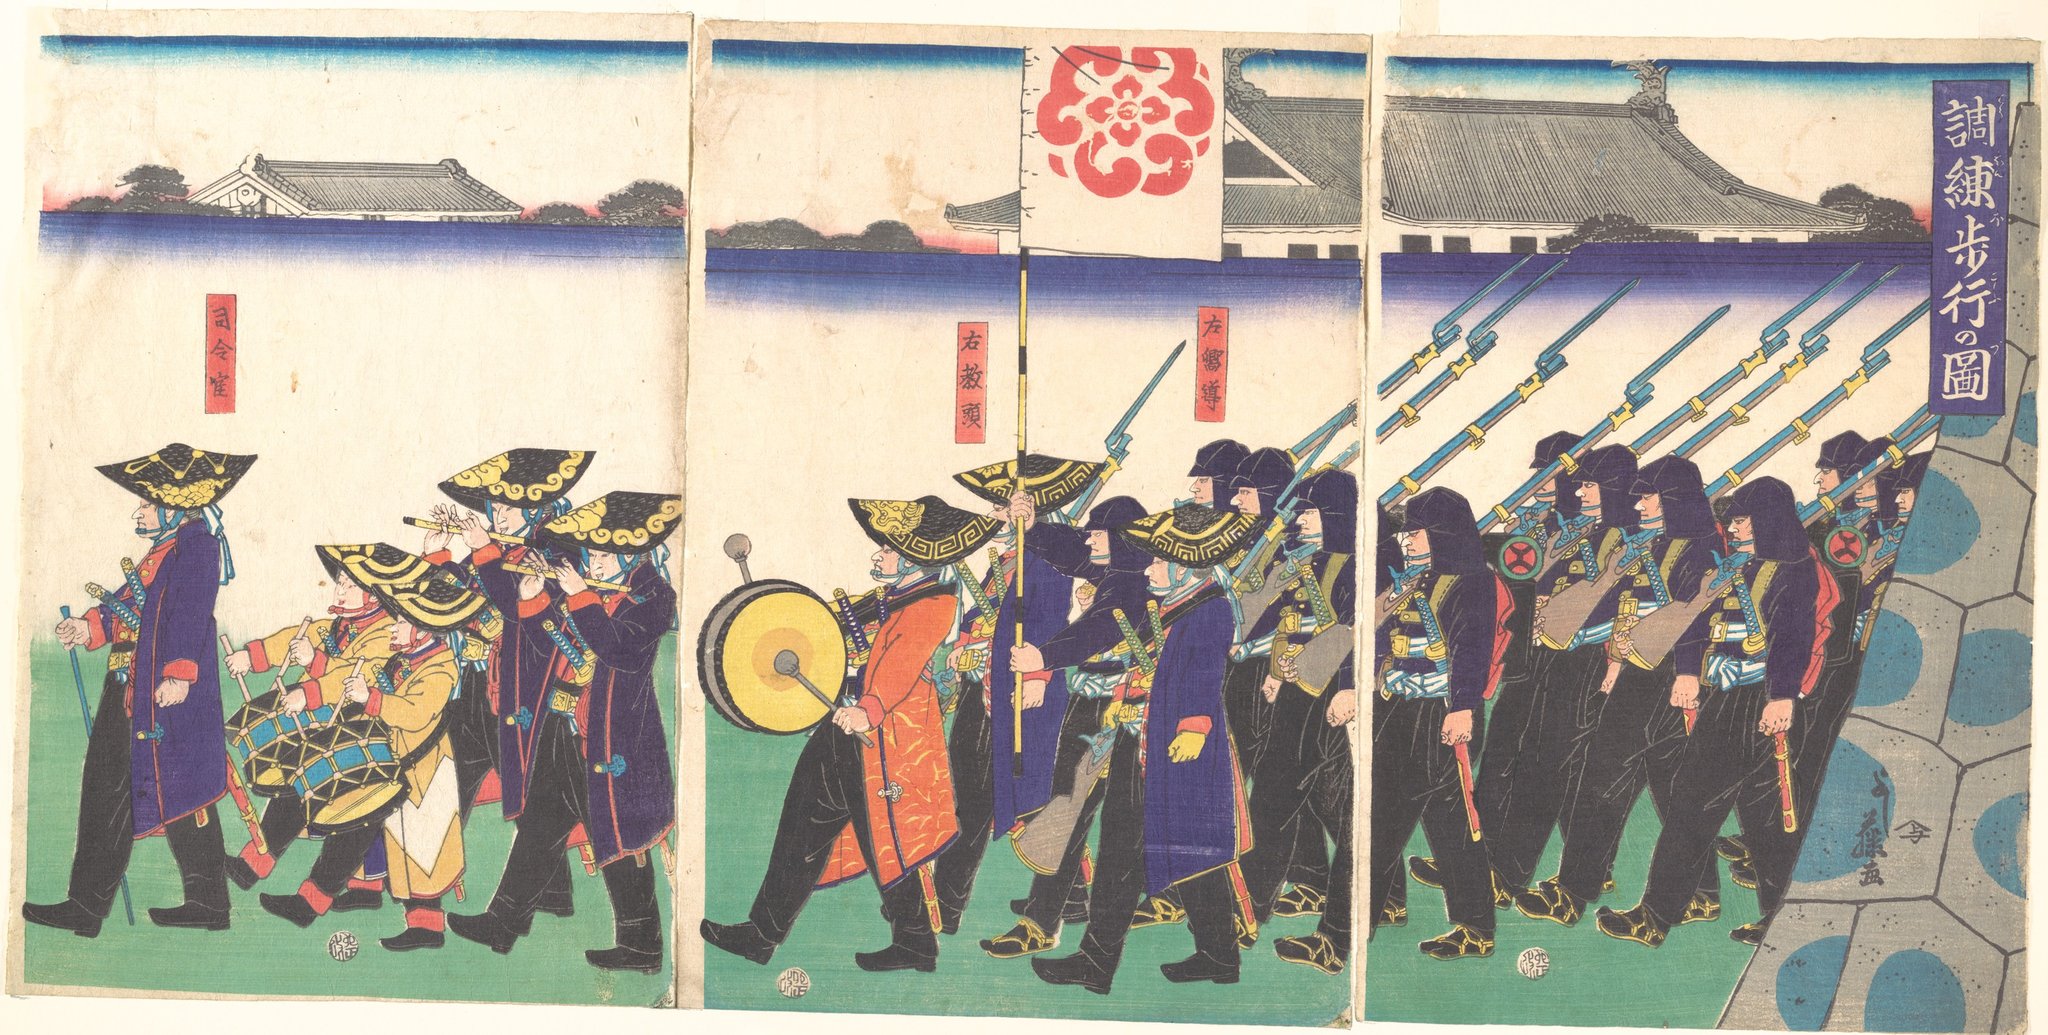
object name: print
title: Parade of the Emperor's Troops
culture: japanese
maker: utagawa yoshifuji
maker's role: artist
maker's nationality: japanese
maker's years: 1828-1887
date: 1867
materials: ink, paper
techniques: woodblock print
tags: musical instruments,soldiers,firearms,men